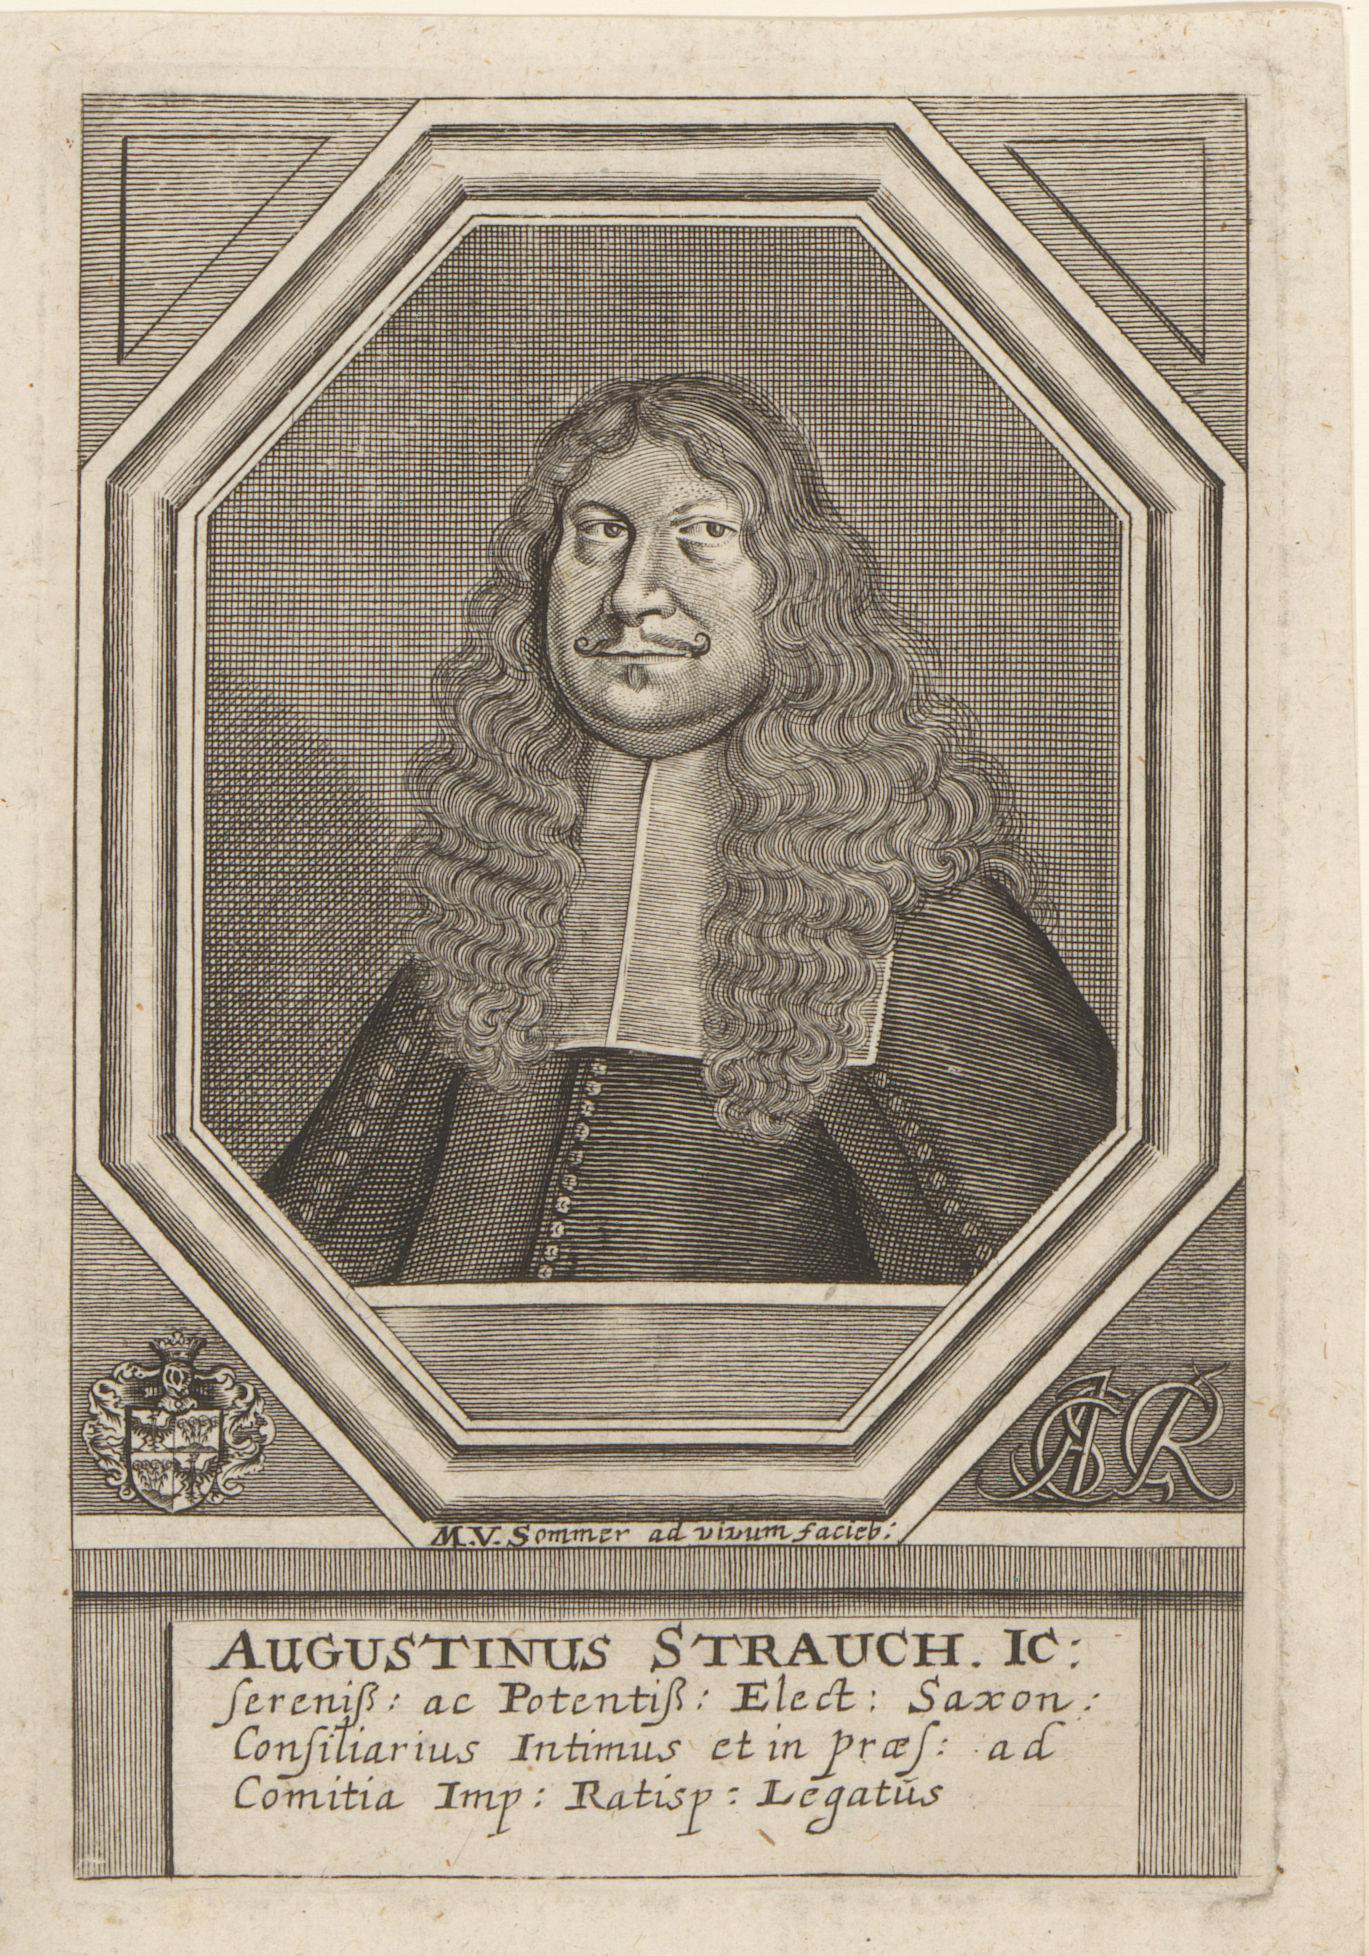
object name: print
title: Portret van Augustin Strauch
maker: matthias van sommer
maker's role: draughtsman, print maker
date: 1665-1672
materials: paper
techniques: engraving, etching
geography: germany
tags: historical persons, armorial bearing, heraldry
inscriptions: collector's mark: Lugt 2228